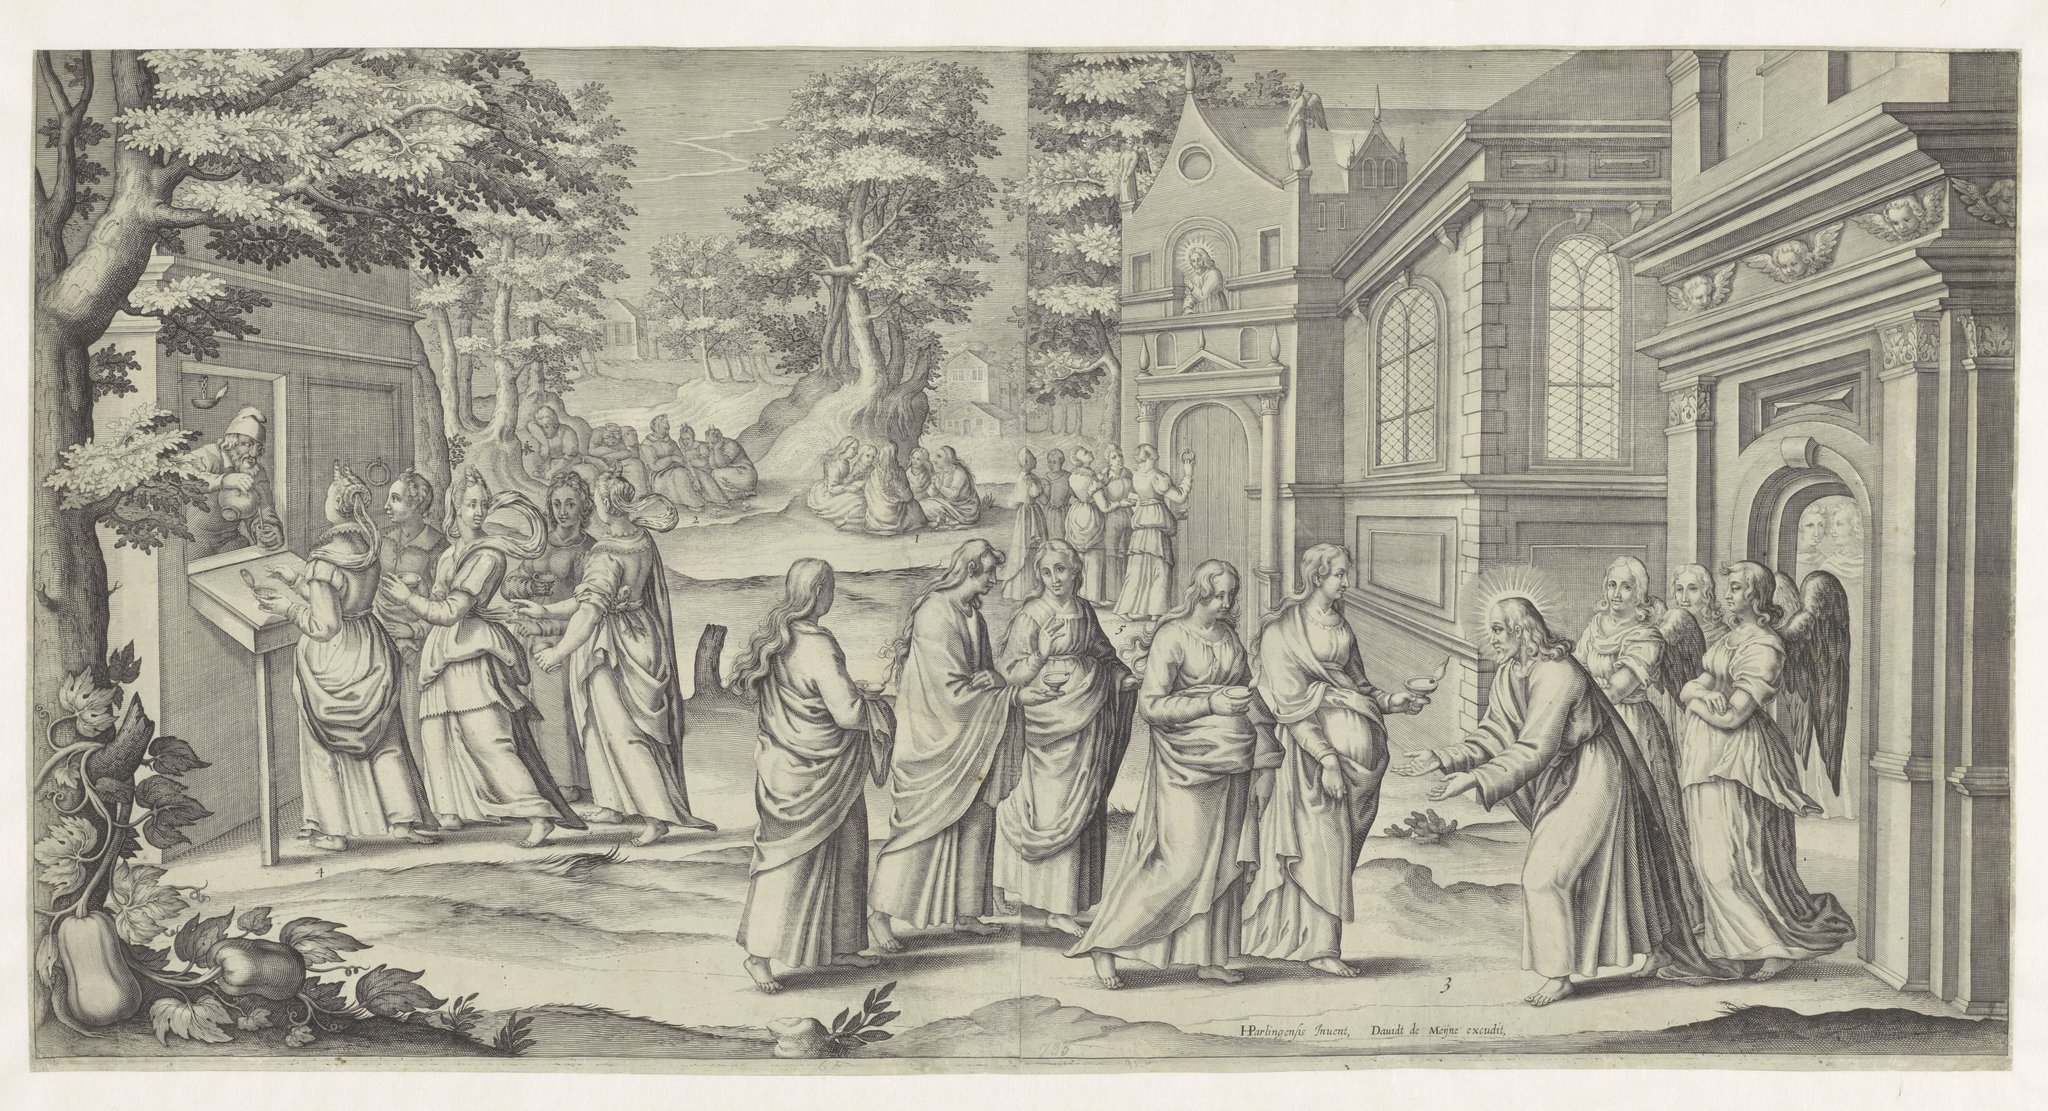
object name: print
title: Gelijkenis van de wijze en dwaze maagden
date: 1600-1620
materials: paper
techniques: engraving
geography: amsterdam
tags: the wise and the foolish virgins ~ parable of christ (matthew 25:1-13)